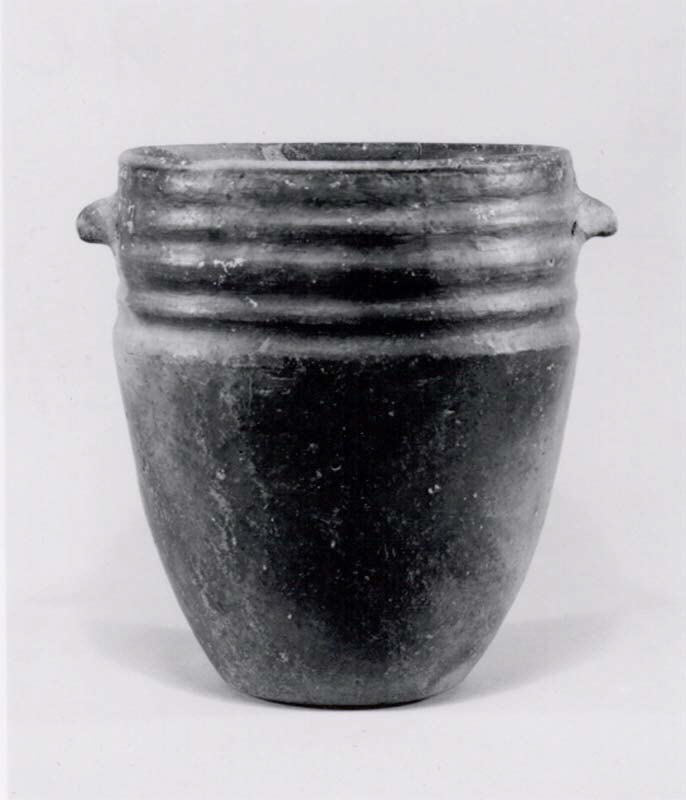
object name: vessel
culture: iranian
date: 900-801 BCE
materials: ceramic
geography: iran